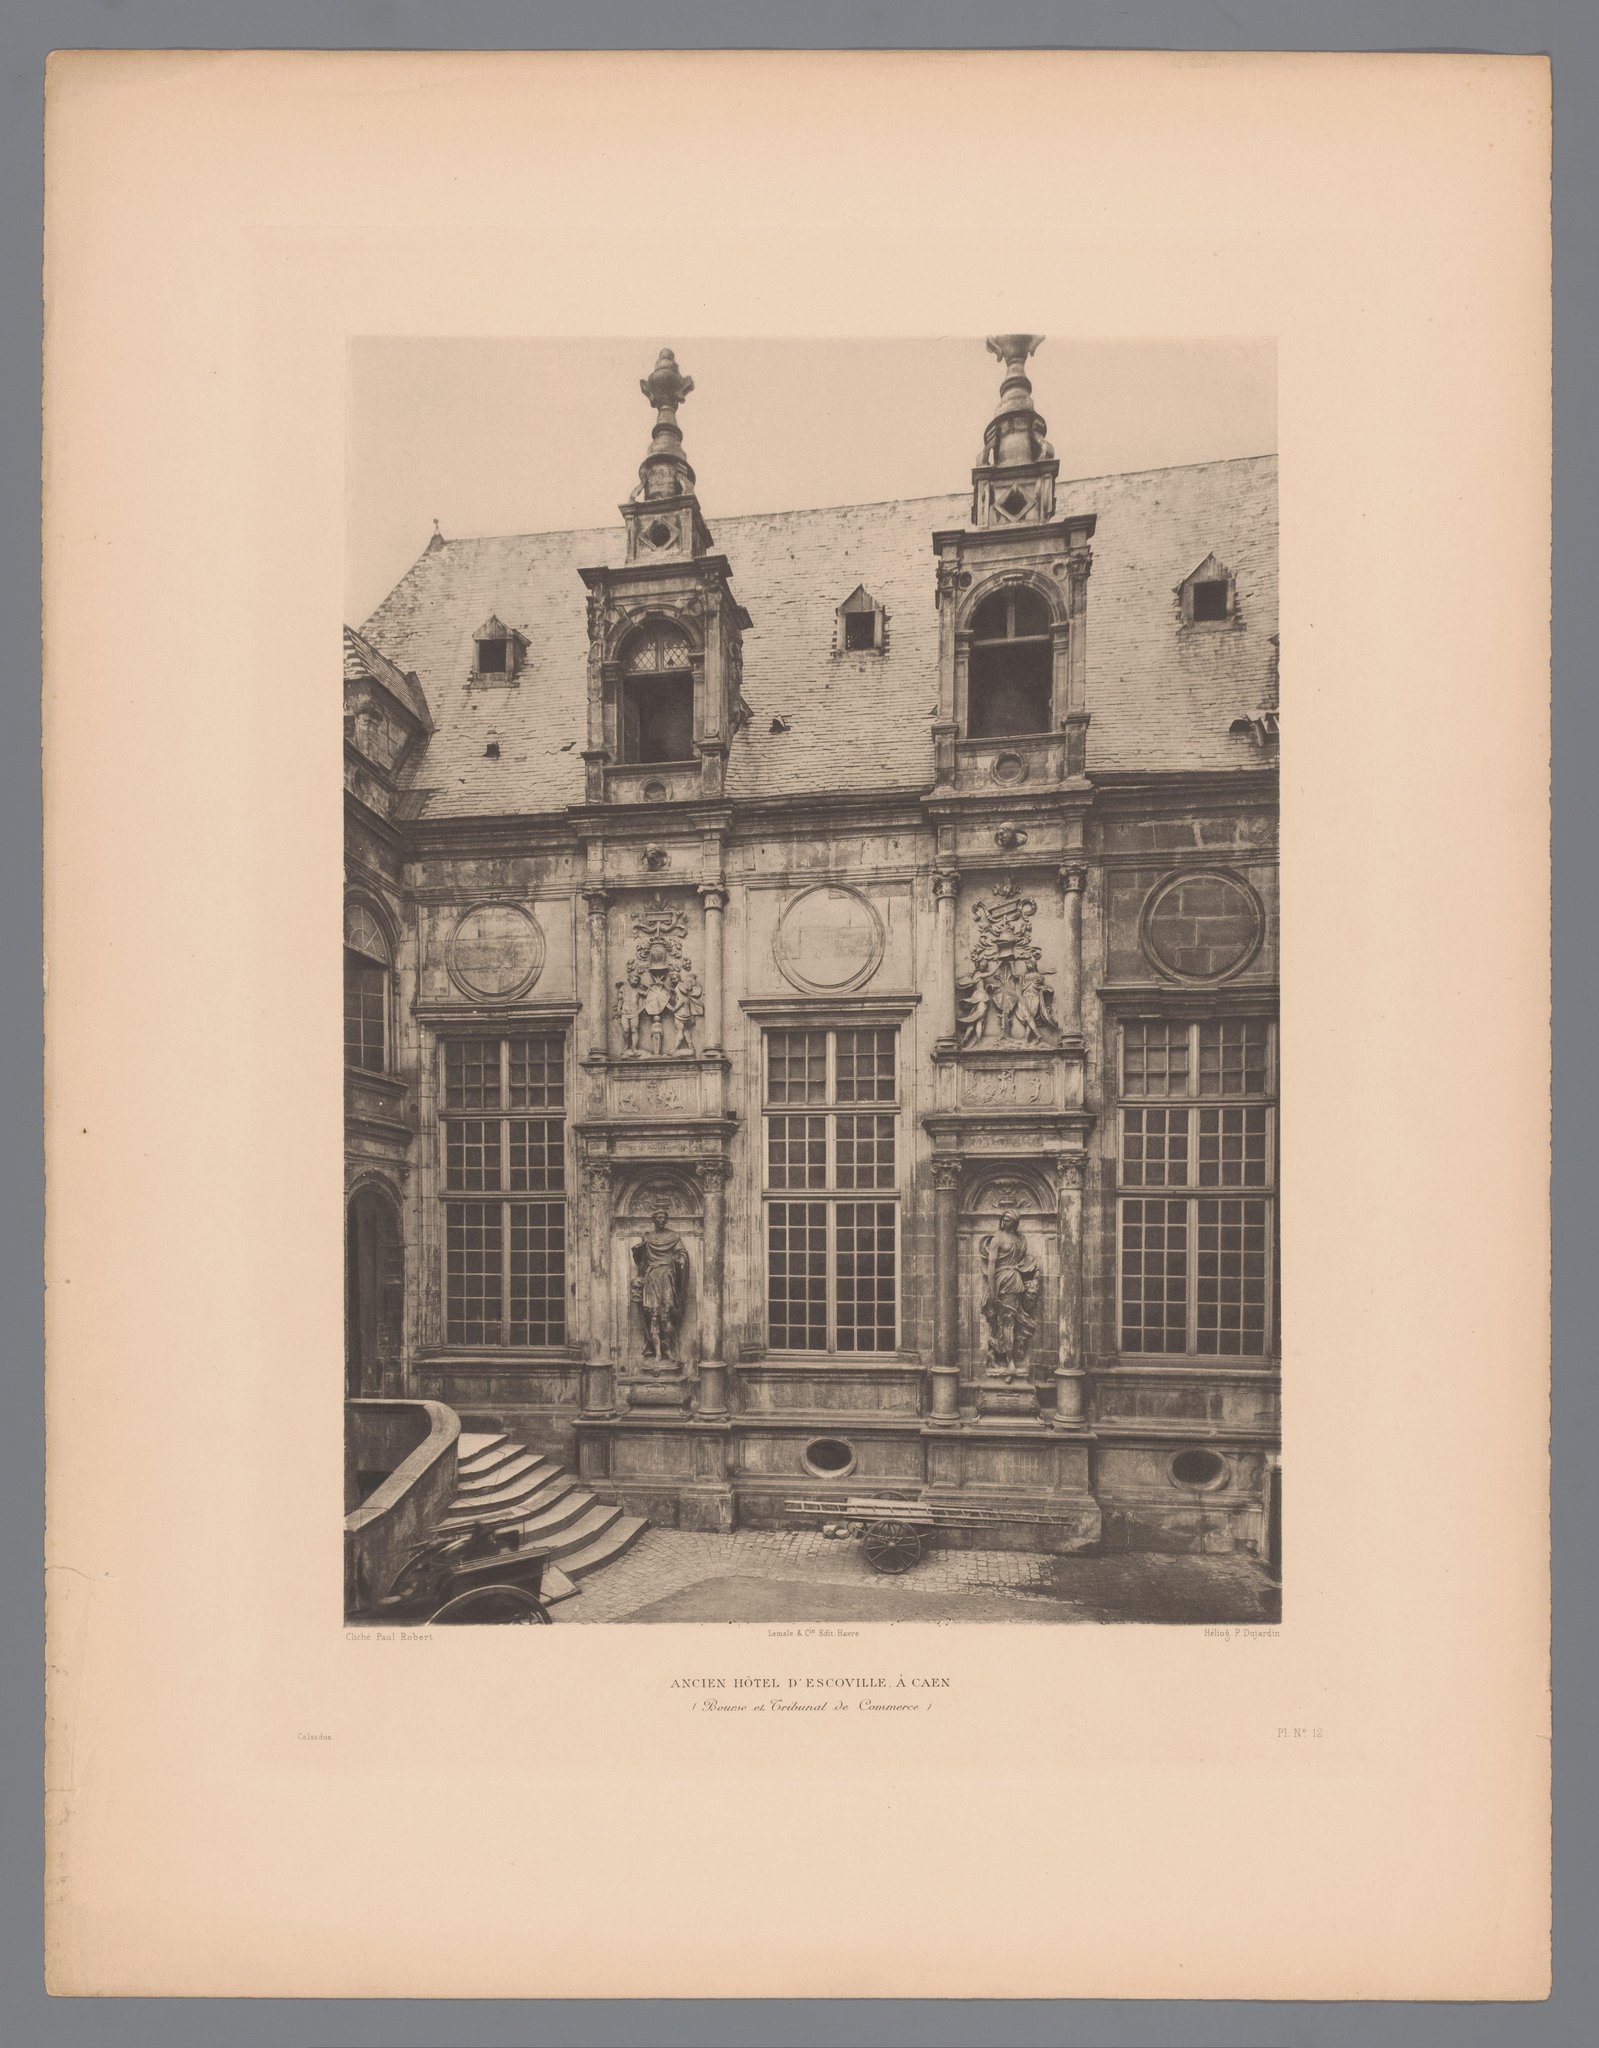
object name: photomechanical print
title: Gezicht op het Hôtel d'Escoville aan de Place Saint-Pierre in Caen, Frankrijk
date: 1890-1895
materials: paper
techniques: photoaquatint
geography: le havre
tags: hotel, hostelry, inn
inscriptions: number: ‘Pl. No. 12’, inscription: ‘Calvados’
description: Deze prent maakt deel uit van een omslag met 12 prenten en 46 tekstbladen.